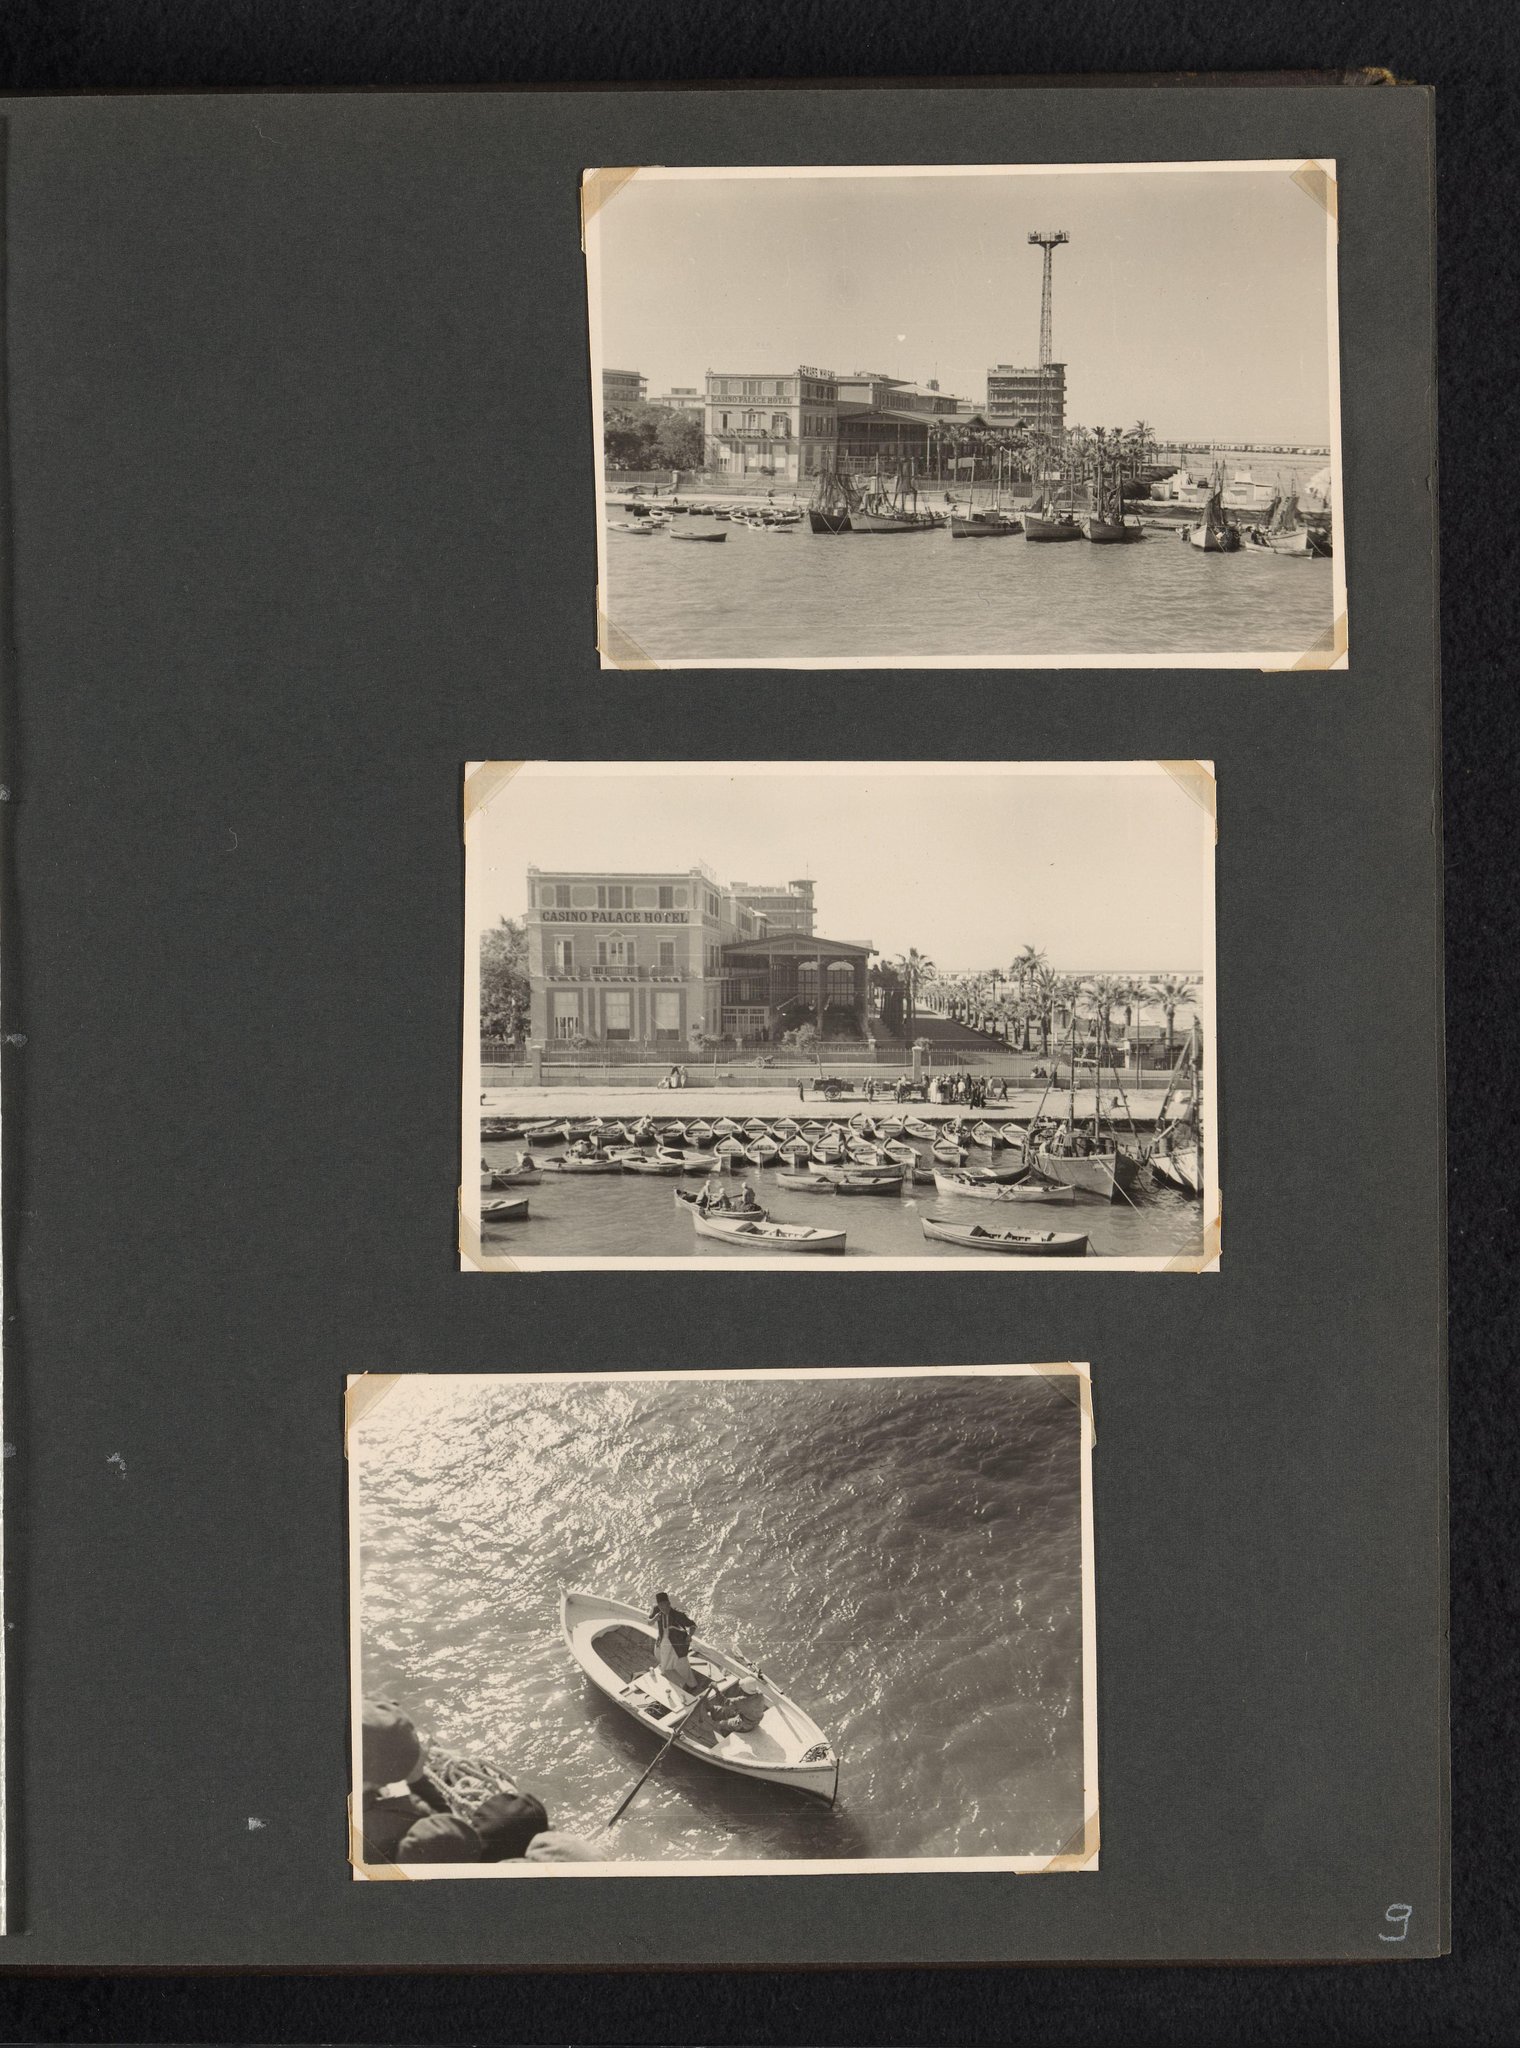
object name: album leaf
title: Port Said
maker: Anonymous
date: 1947-1948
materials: cardboard, photographic support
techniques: gelatin silver print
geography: port said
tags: troop movements, transportation, rowing-boat, canoe, etc., hotel, hostelry, inn, steamship, motorship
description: Albumblad met drie foto's van het Casino Palace Hotel in Port Said en Egyptisch bootje langszij, genomen vanaf de S.S. Waterman op weg naar Nederlands-Indië. Onderdeel van het fotoalbum 'Mijn jaren in Indië' met foto's over de militaire acties in Nederlands-Indië.